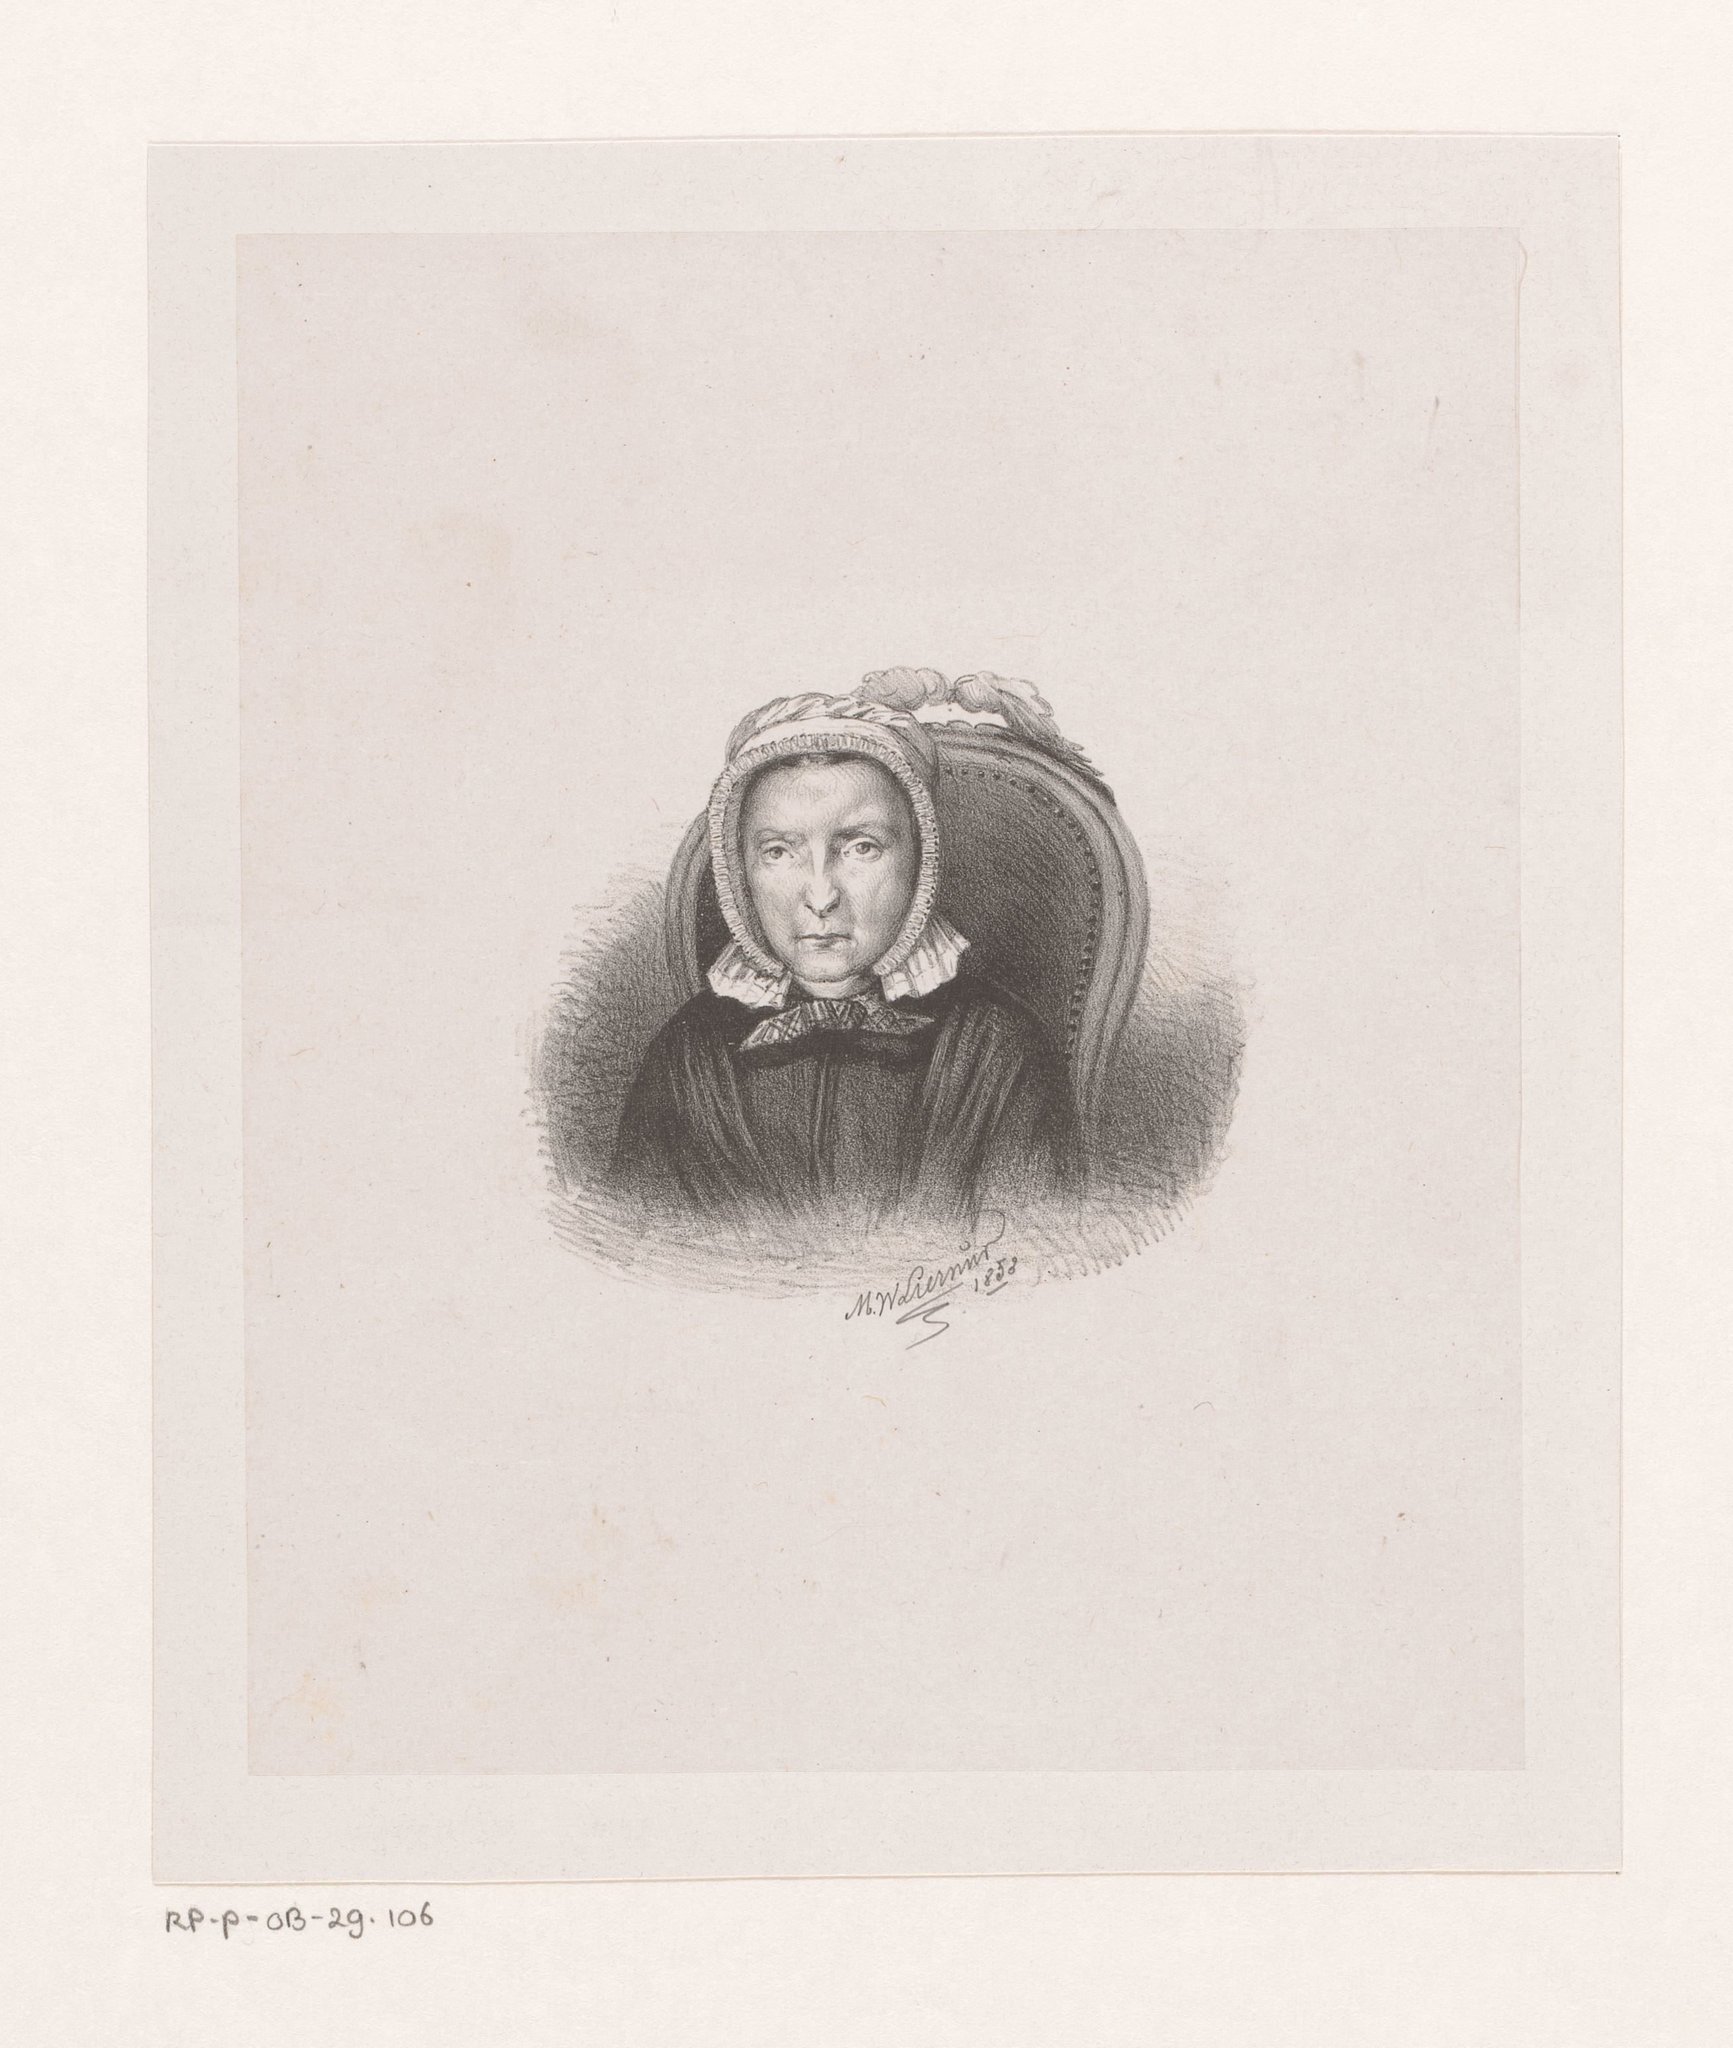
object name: print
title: Portret van een oude vrouw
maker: martinus wilhelmus liernur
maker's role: print maker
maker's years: 1833-1901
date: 1853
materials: paper, pencil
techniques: lithograph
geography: the hague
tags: armchair, seat, historical persons - bb - woman (+ (full) bust portrait), head-gear: cap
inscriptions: collector's mark: Lugt 2228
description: De vrouw draagt een kanten muts en zit in een fauteuil.